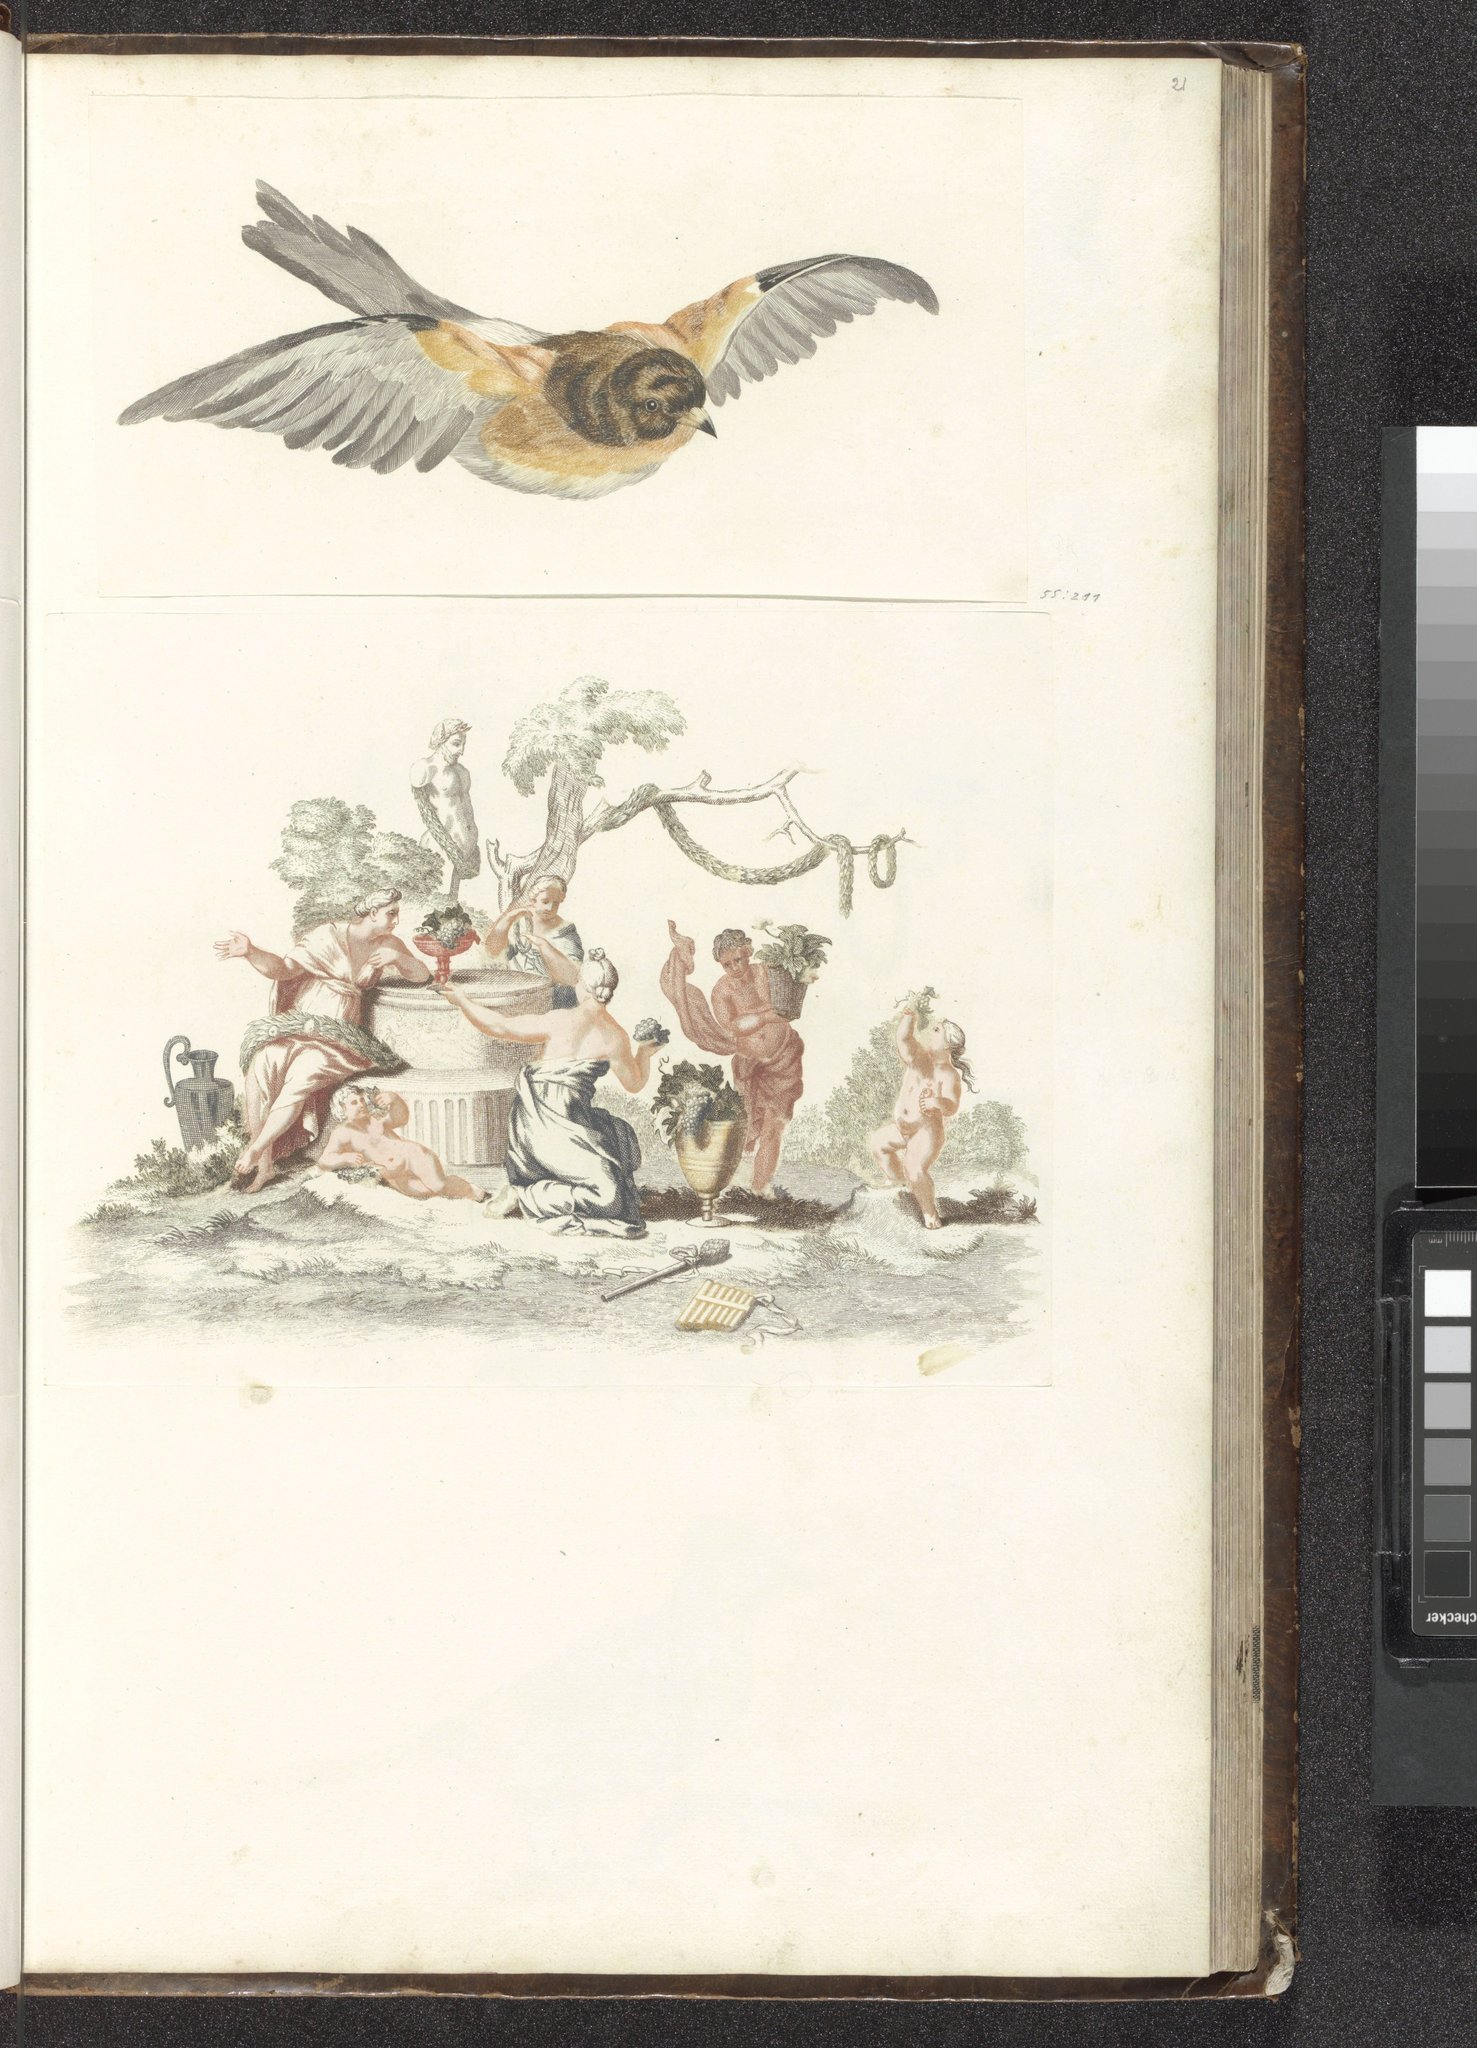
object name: album leaf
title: Maenaden bij een altaar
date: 1688-1698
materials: paper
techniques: etching, hand coloring, lithography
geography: netherlands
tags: thyrsus ~ attribute of bacchus, maenad(s), female bacchant(es), other hybrid forms in the shape of a pillar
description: Maenaden of Bacchanten rond een offerzuil voor een herme. Op de zuil zet een maenade een schaal met druiven. Op de grond liggen een thyrsus en een panfluit. Deze prent maakt deel uit van een album.